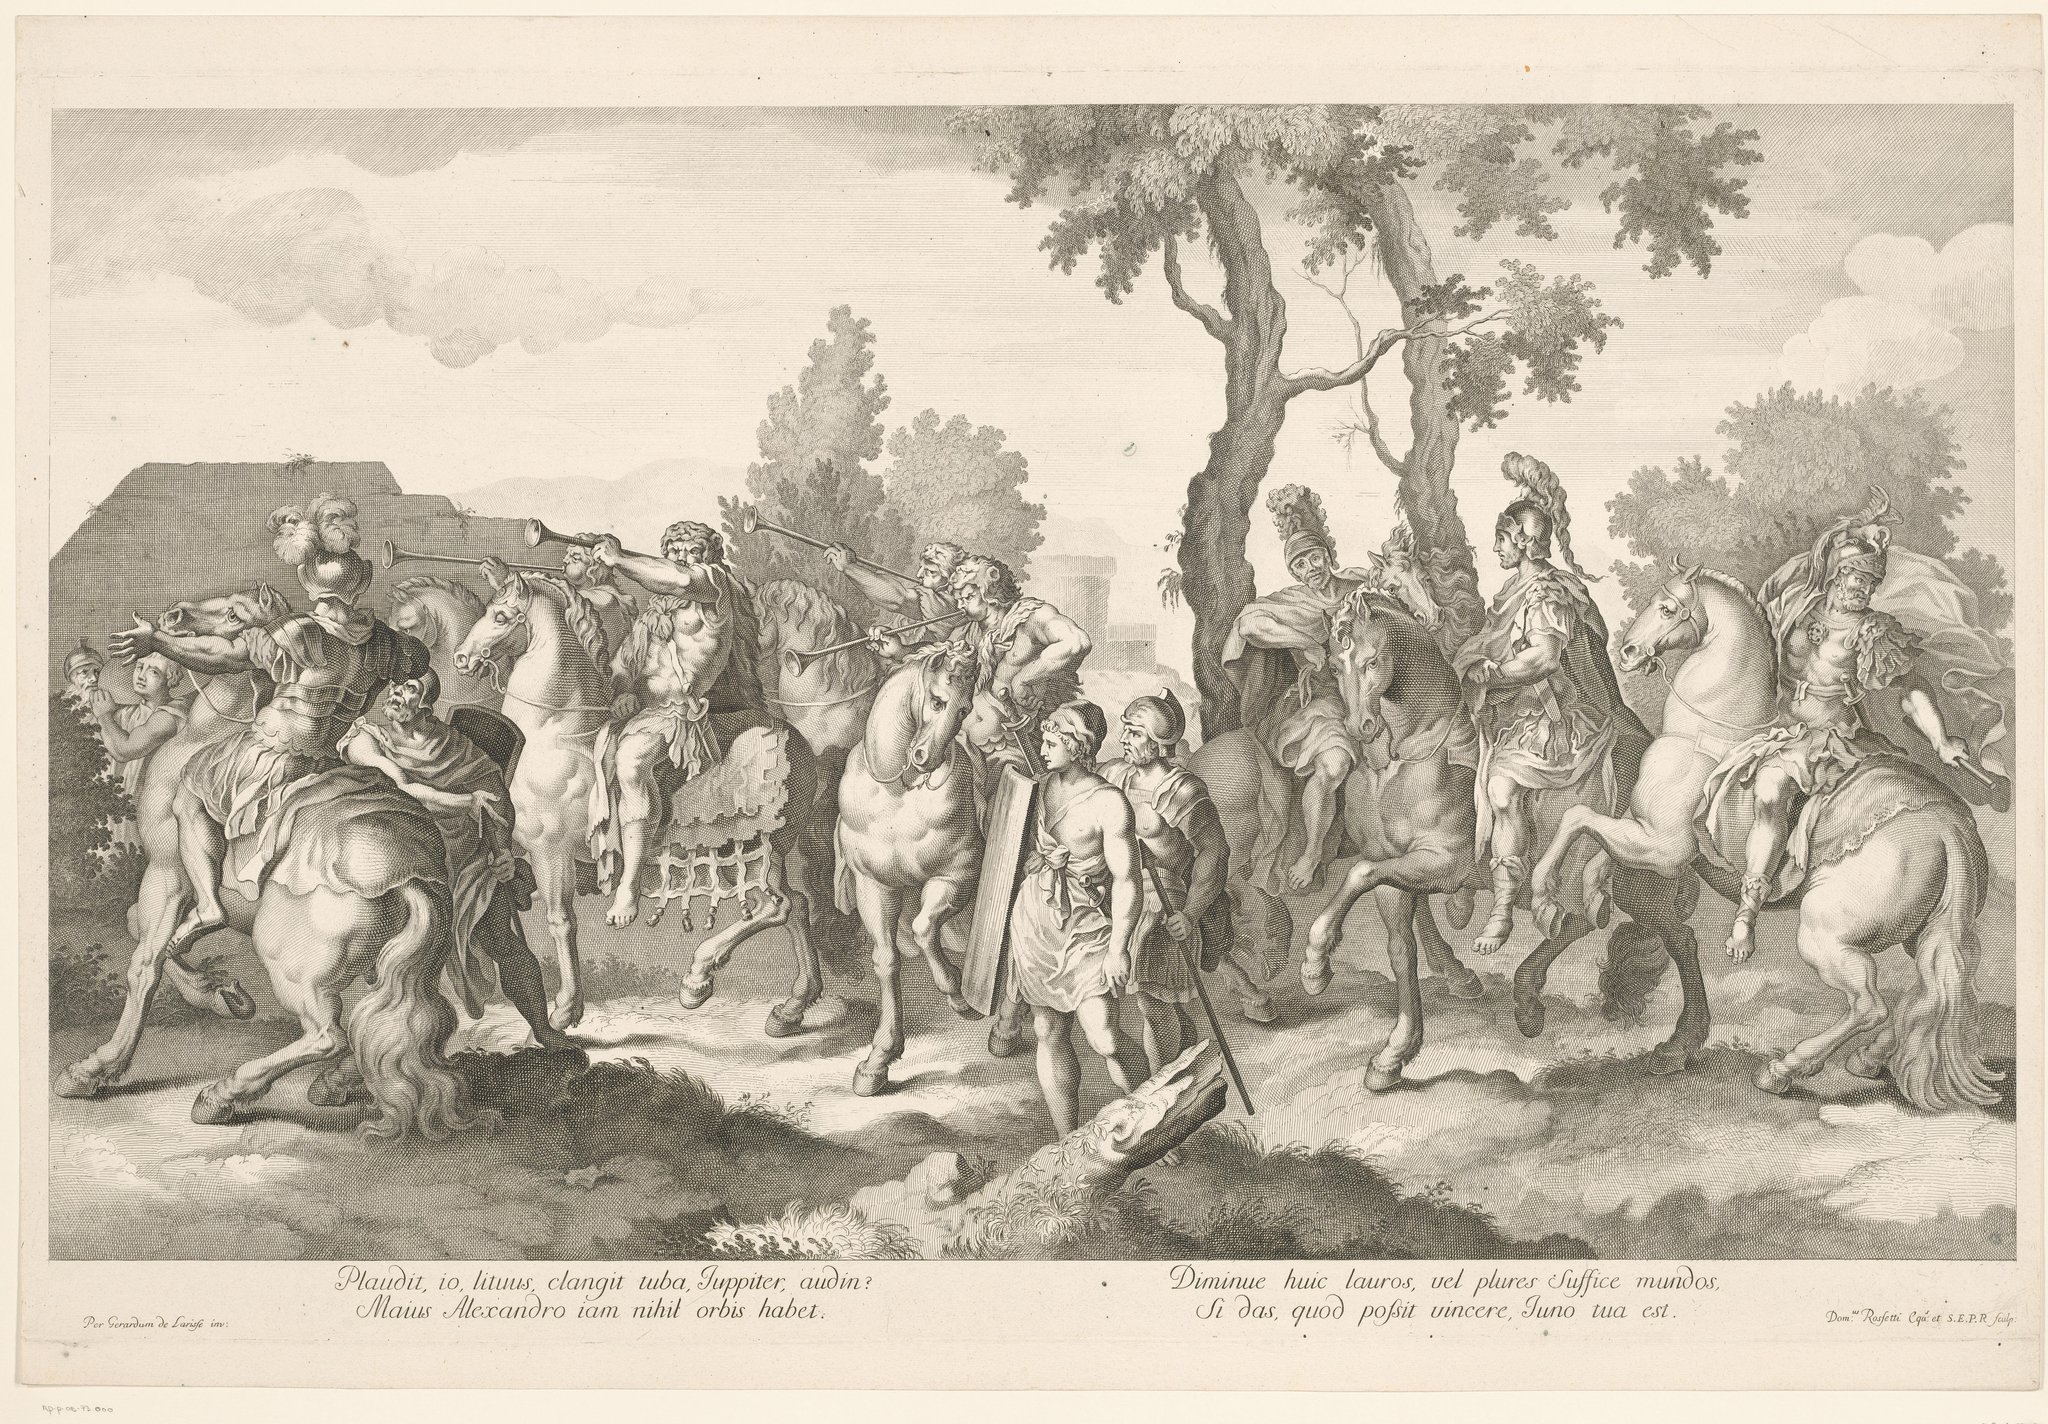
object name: print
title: Triomftocht van Alexander de Grote in Babylon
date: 1660-1736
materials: paper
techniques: engraving, etching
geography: italy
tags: landscape with ruins, the soldier; the soldier's life, prisoner of war (after the battle), carrying off the spoils of war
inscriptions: collector's mark: Lugt 2228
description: Deze prent maakt deel uit van een reeks van twaalf prenten door verschillende prentmakers naar de grisailles door Gerard de Lairesse in Schloss Mannheim van de Triomftocht van Alexander de Grote in Babylon.